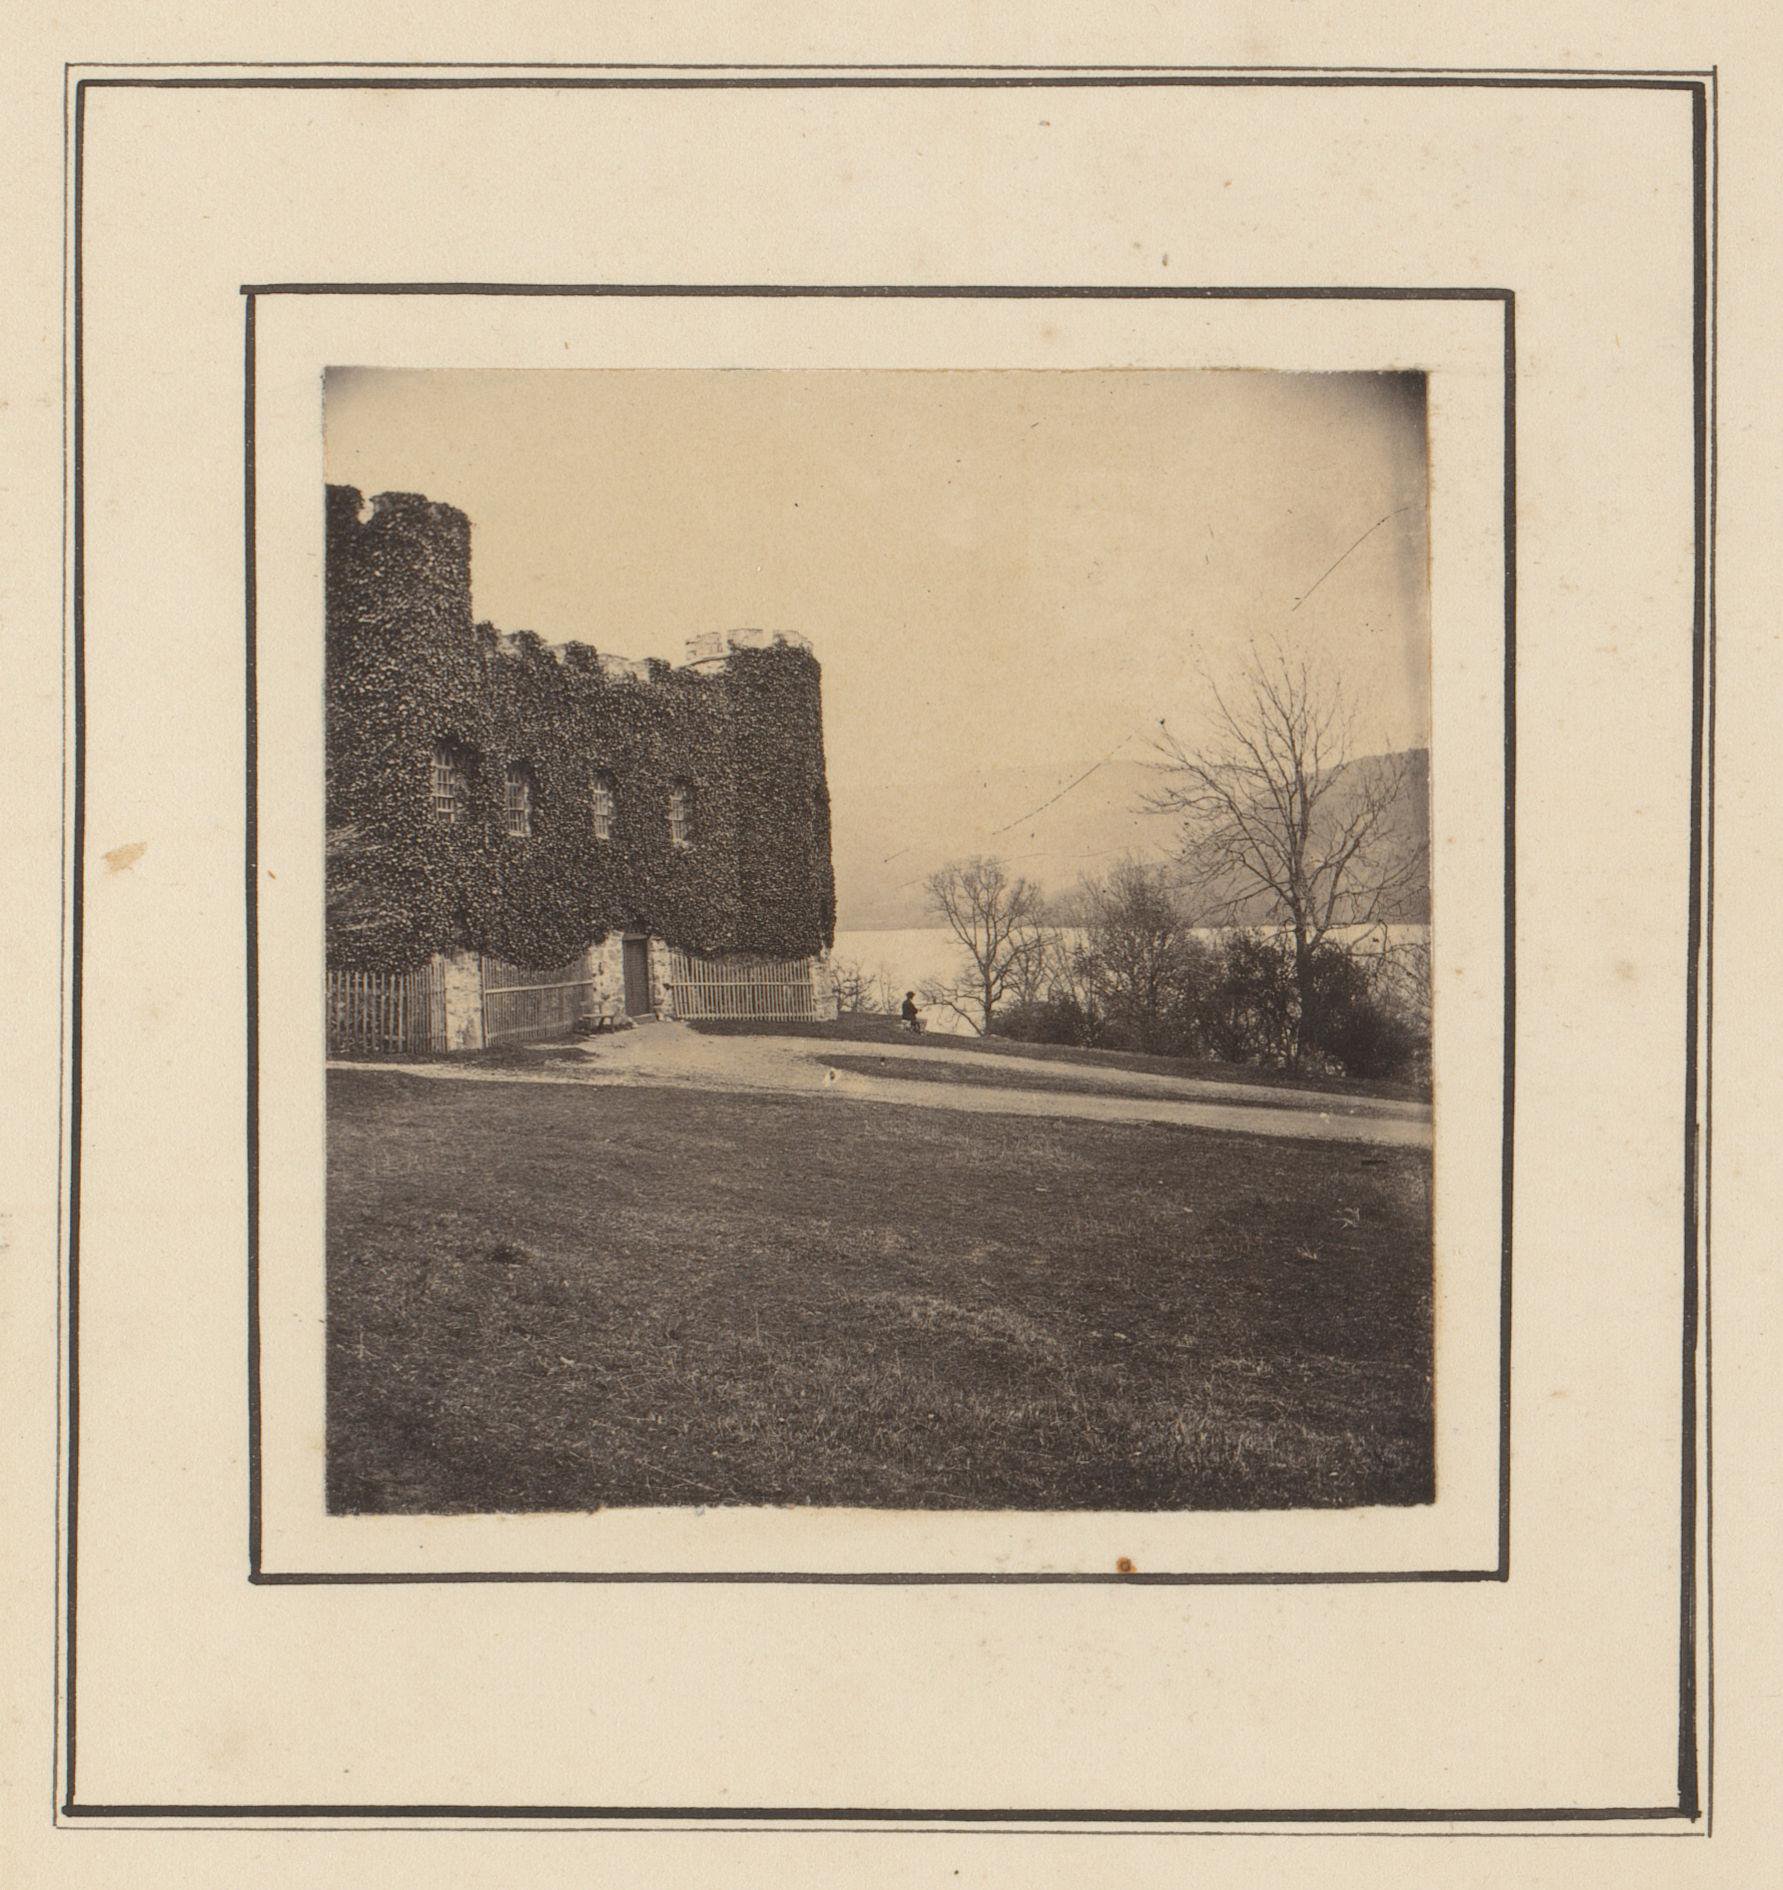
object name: photograph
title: Tower - Airy force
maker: Anonymous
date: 1870-1890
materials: paper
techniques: albumen print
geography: lake district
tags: castle, lake